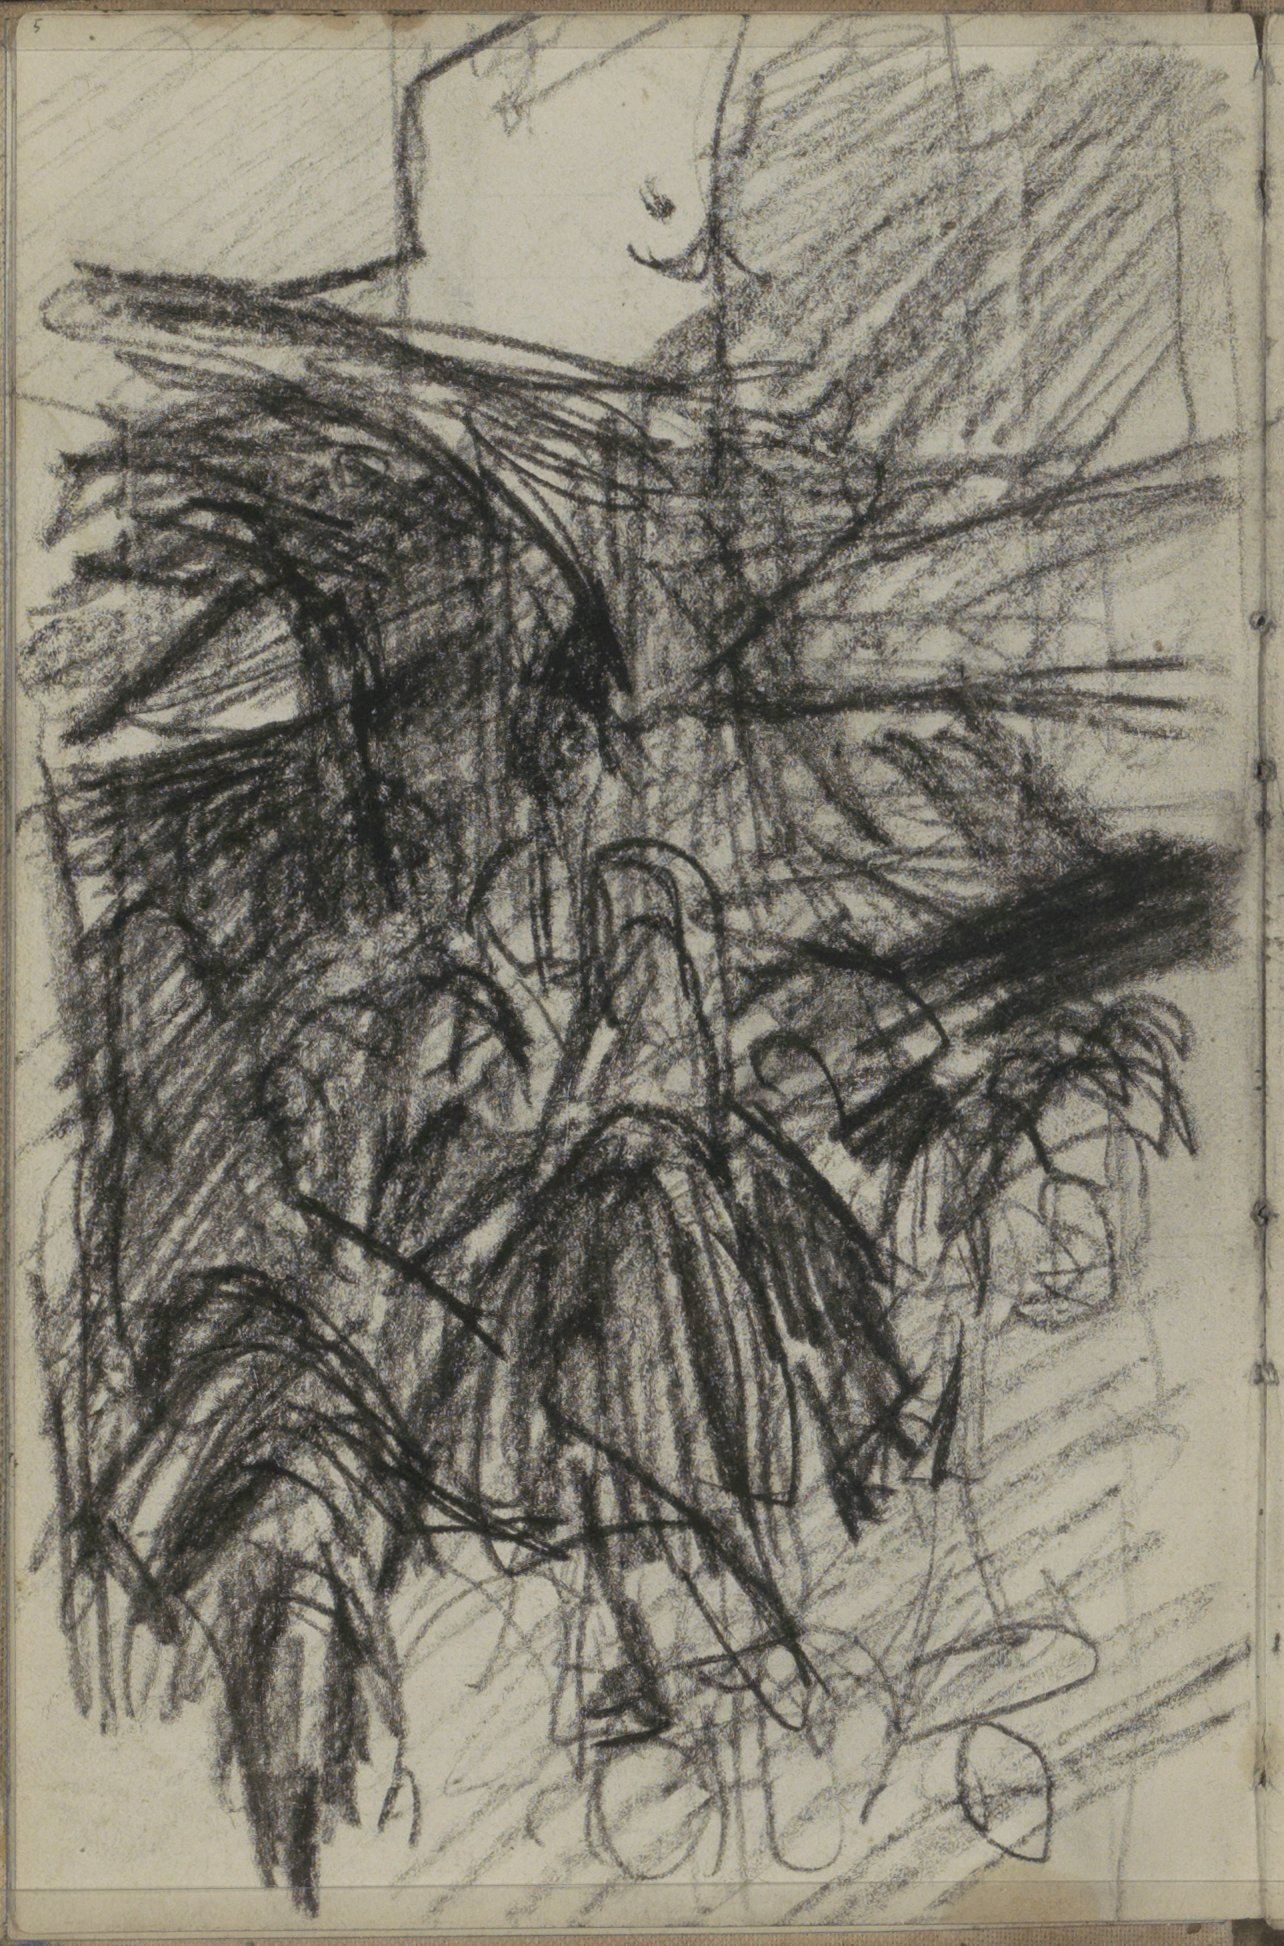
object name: sketchbook leaf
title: Figuren bij een poort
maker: marius bauer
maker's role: draughtsman, print maker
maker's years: 1867-1932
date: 1888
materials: chalk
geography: istanbul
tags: arch, archivolt ~ architecture, street (+ city(-scape) with figures, staffage)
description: Pagina 5 uit een schetsboek met 58 bladen.